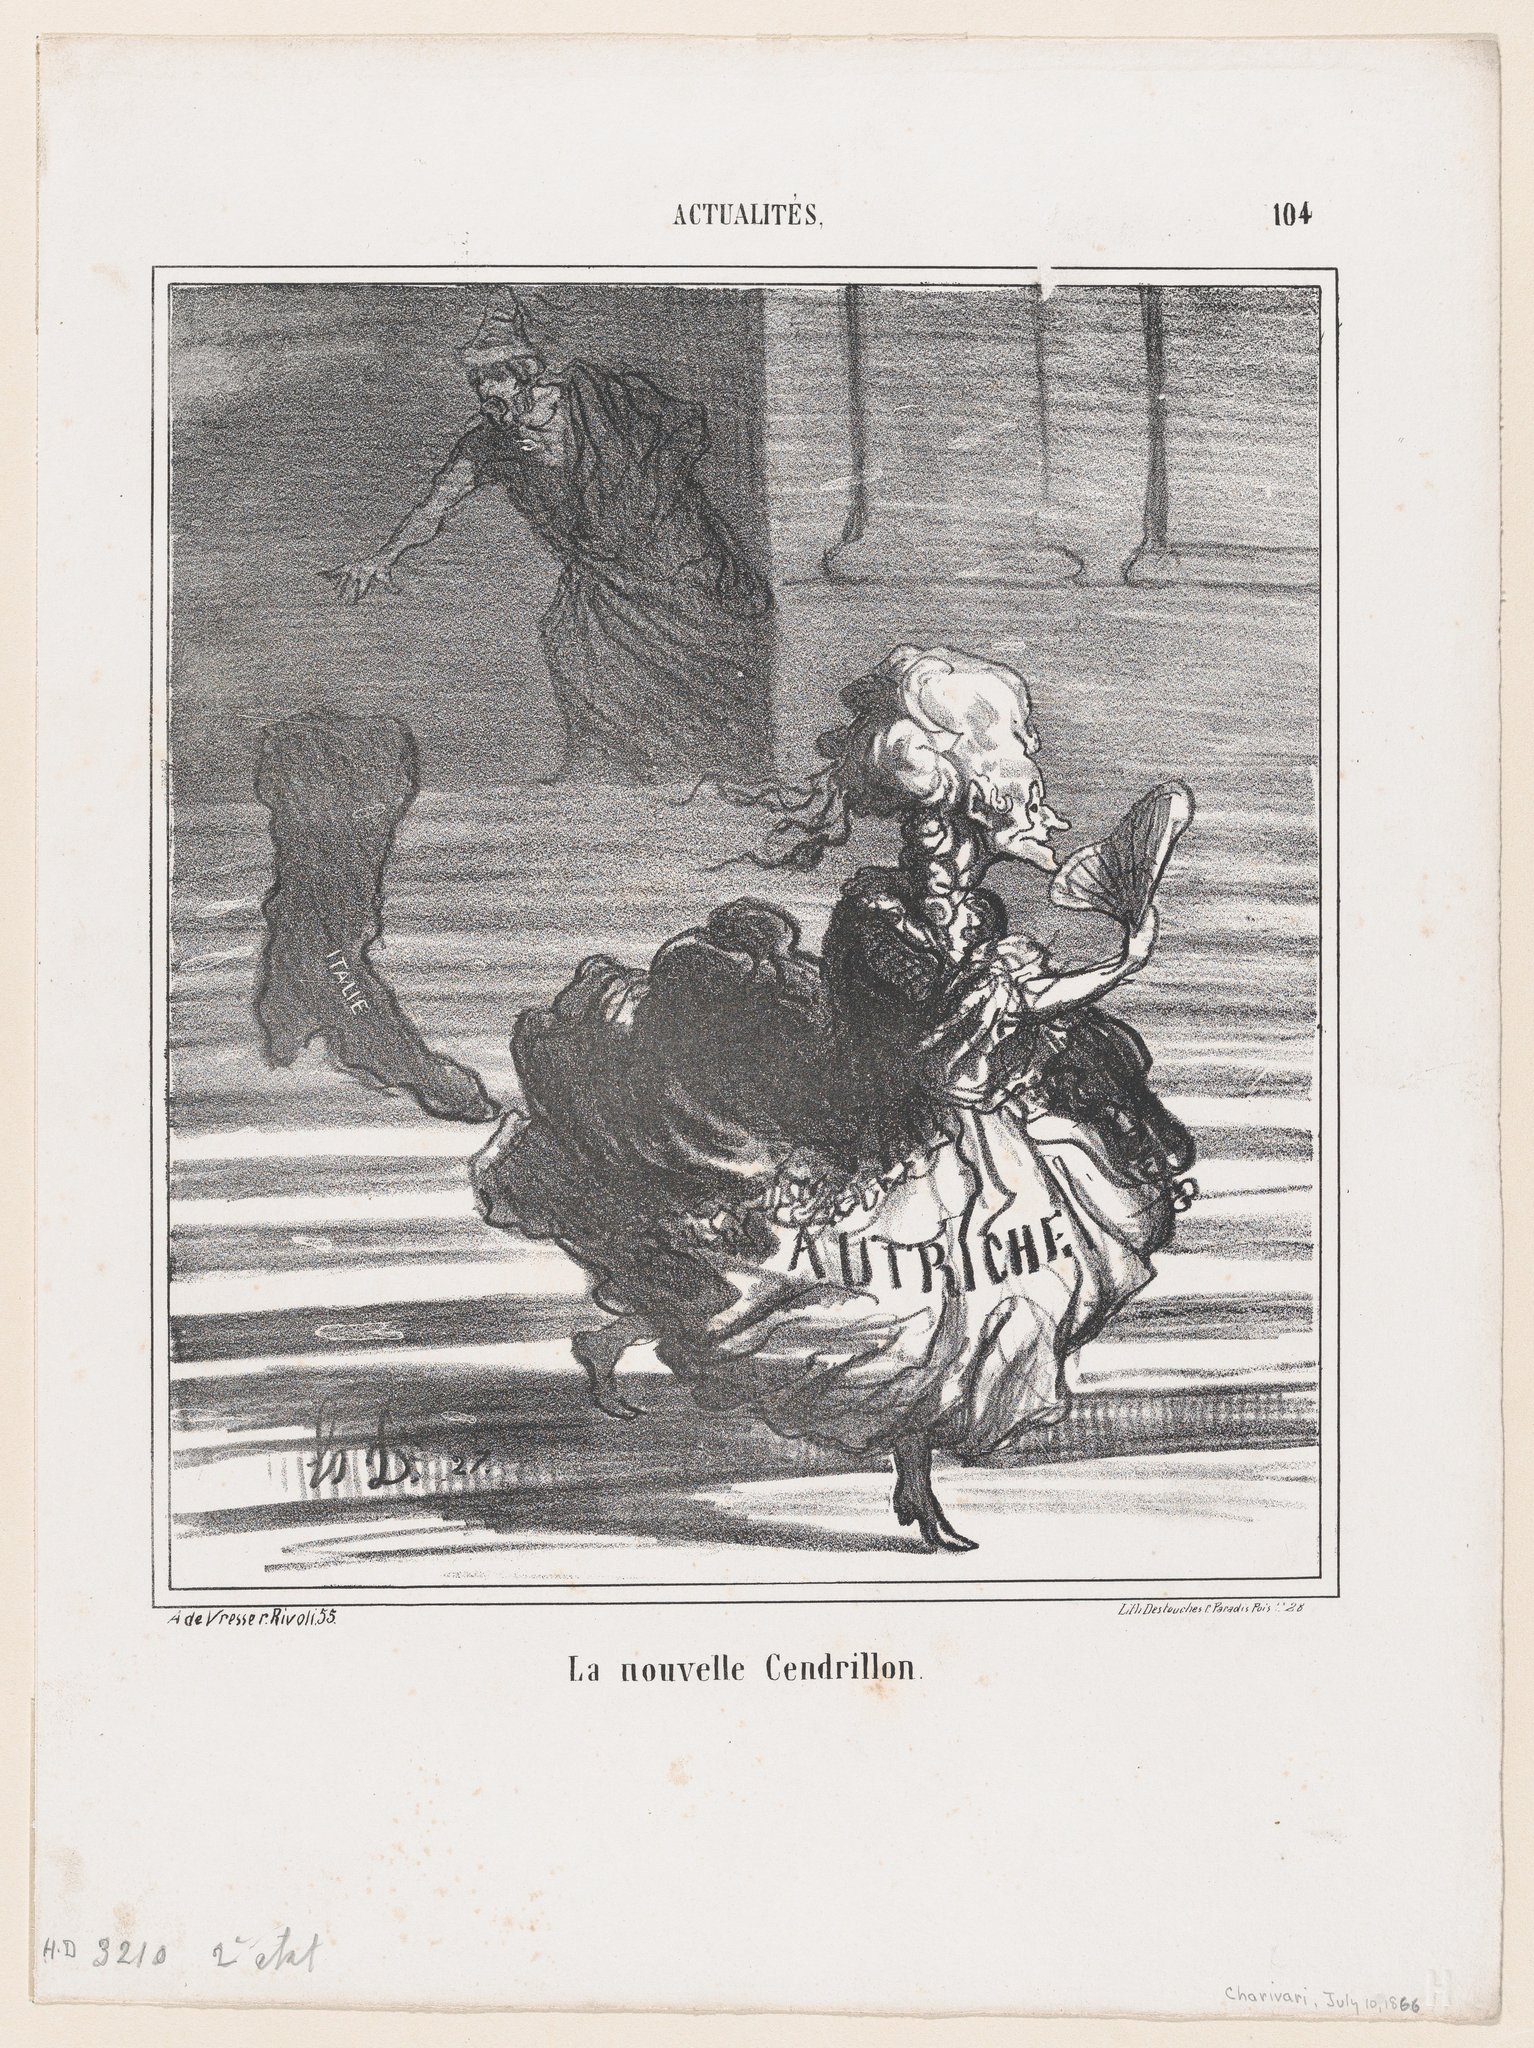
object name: print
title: The new Cinderella, from 'News of the day,' published in "Le Charivari"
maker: honoré daumier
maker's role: artist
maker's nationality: french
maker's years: 1808-1879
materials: paper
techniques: lithograph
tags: men,women